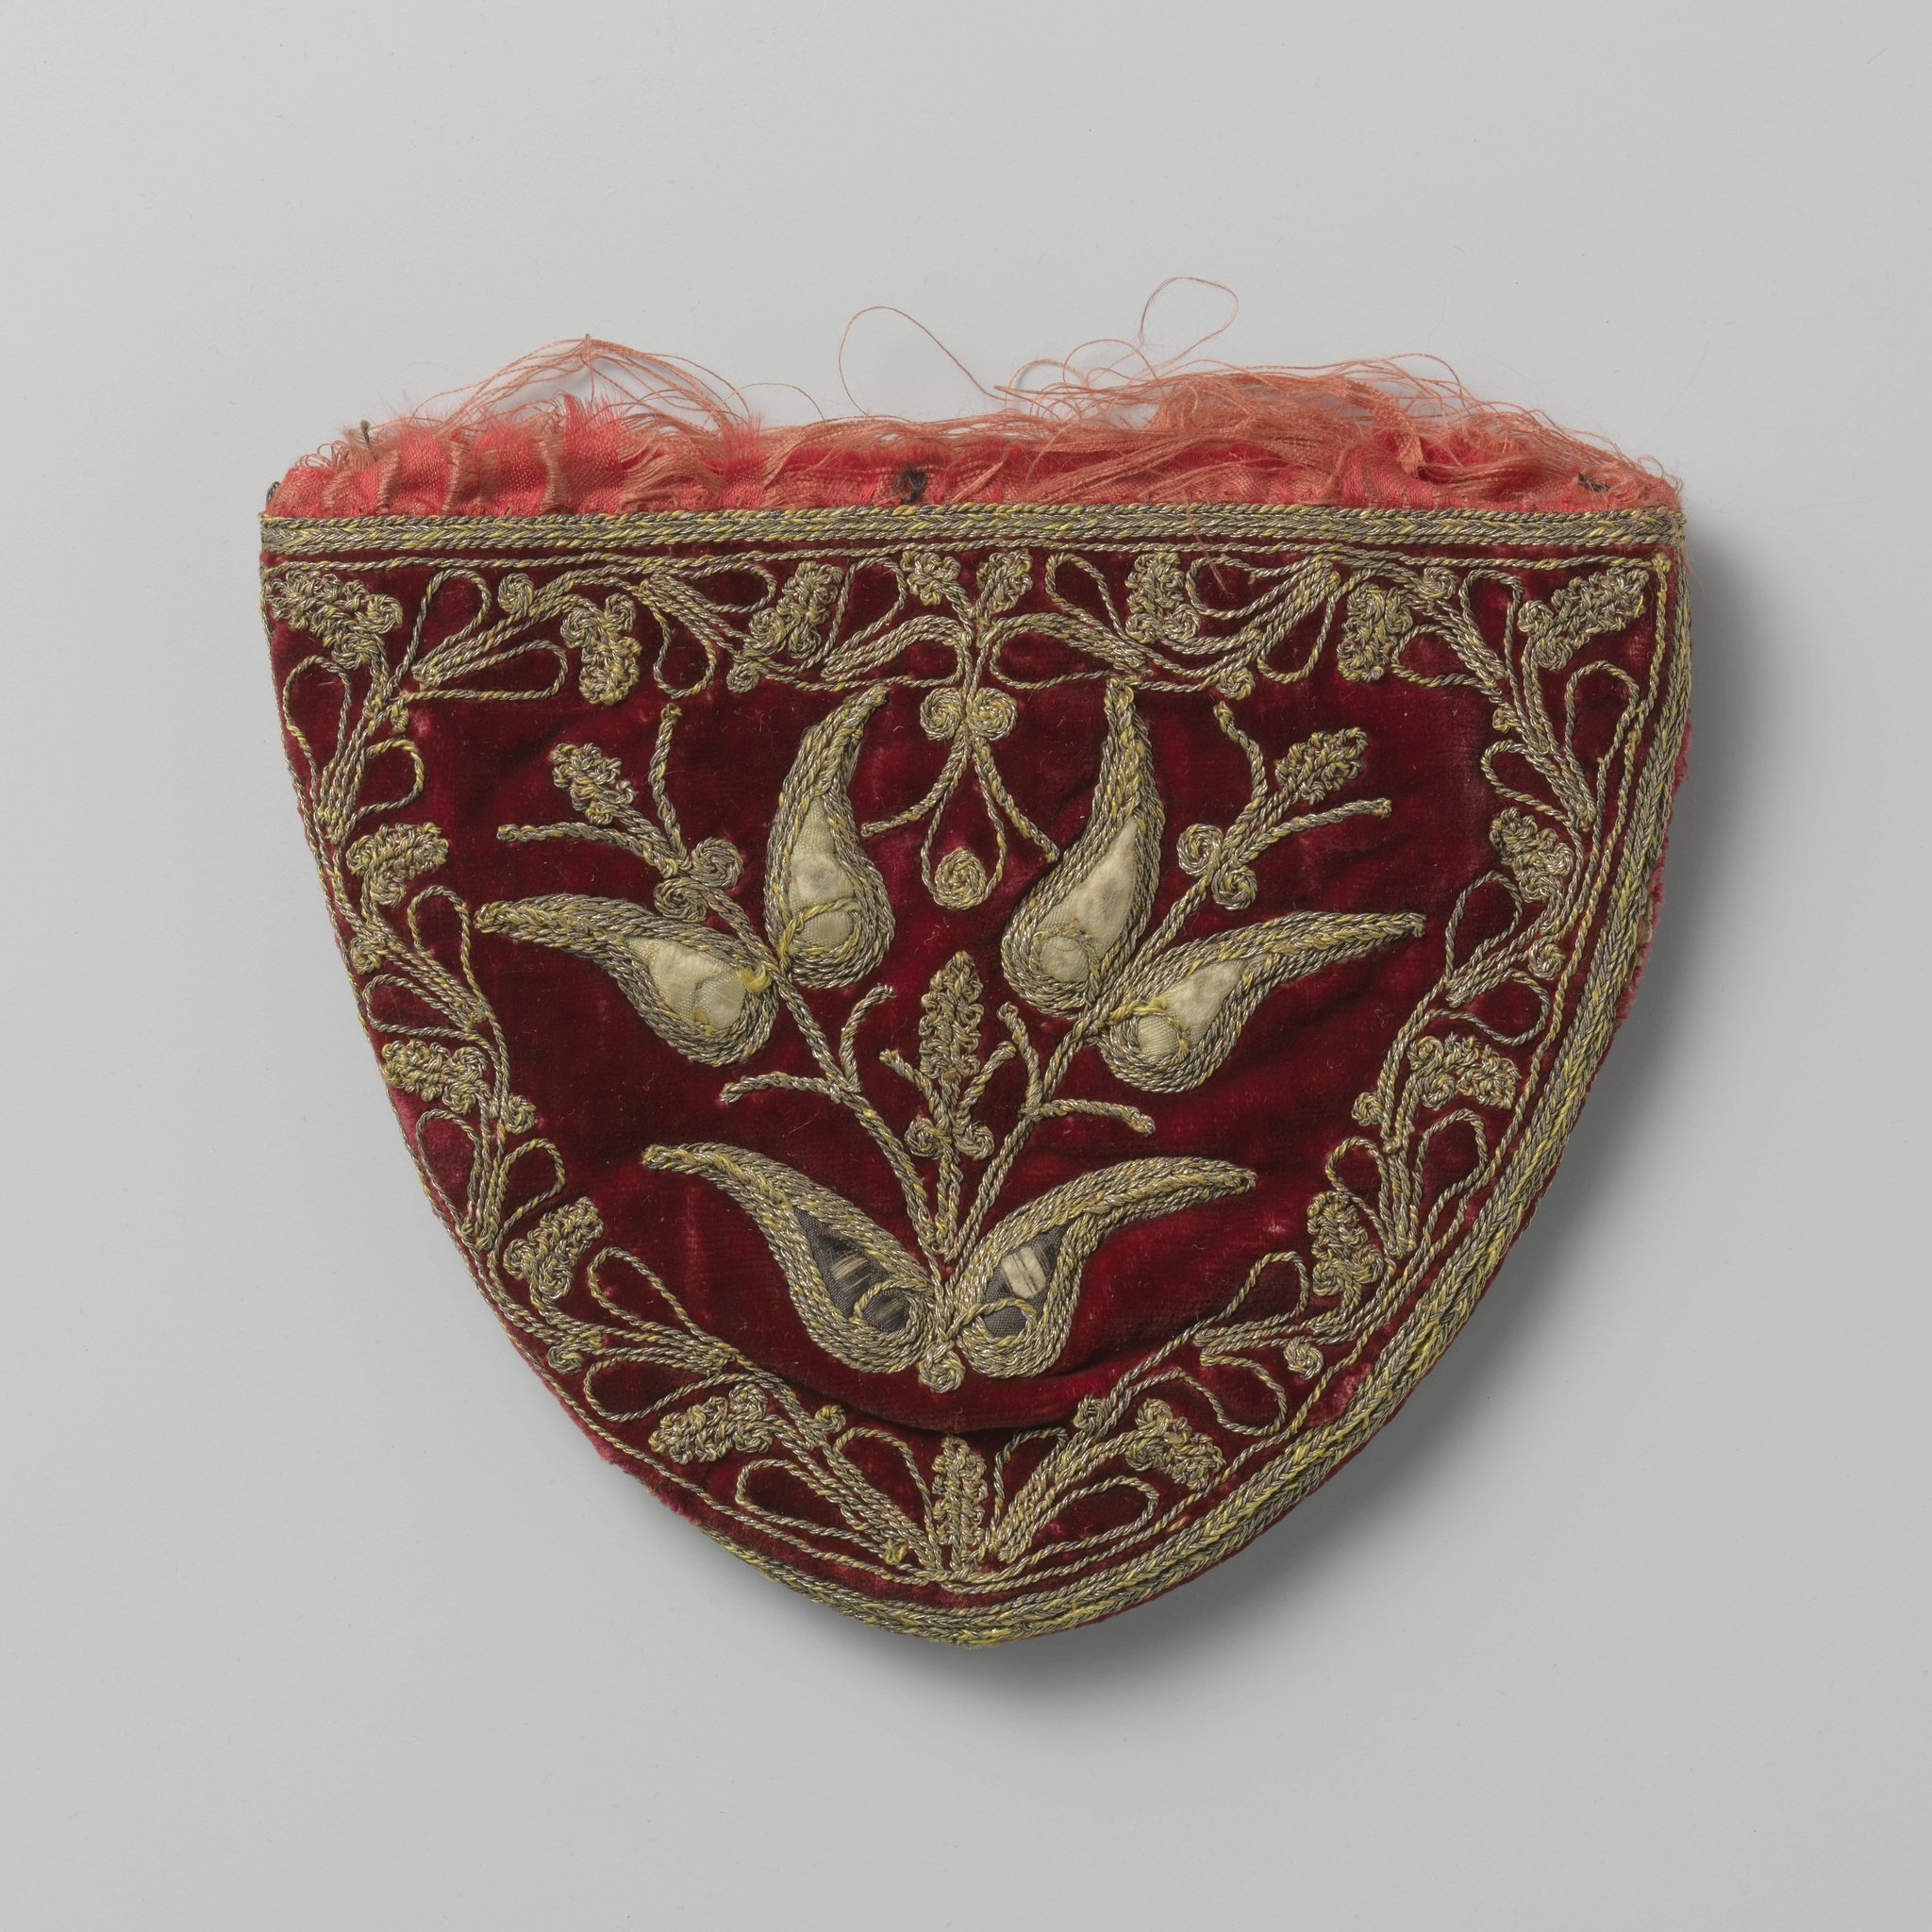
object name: beurs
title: Beursje in een plat, schildvormig model, van paarsrood fluweel, in reliëf geborduurd met gouddraad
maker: Anonymous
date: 1500-1700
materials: gold thread, velvet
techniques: embroidered, weave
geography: italy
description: Beursje van paarsrood fluweel, in reliëf geborduurd met gouddraad. Twee schildvormige pattes plat aan elkaar genaaid. Patroon aan beide zijden gelijk. Ontspringend aan twee lancetbladeren in grijs met gouden randen groeien twee symmetrische takken, ieder met twee dito bladeren in wit. Omranding van lopende rank met tros en blaadjes in goud.